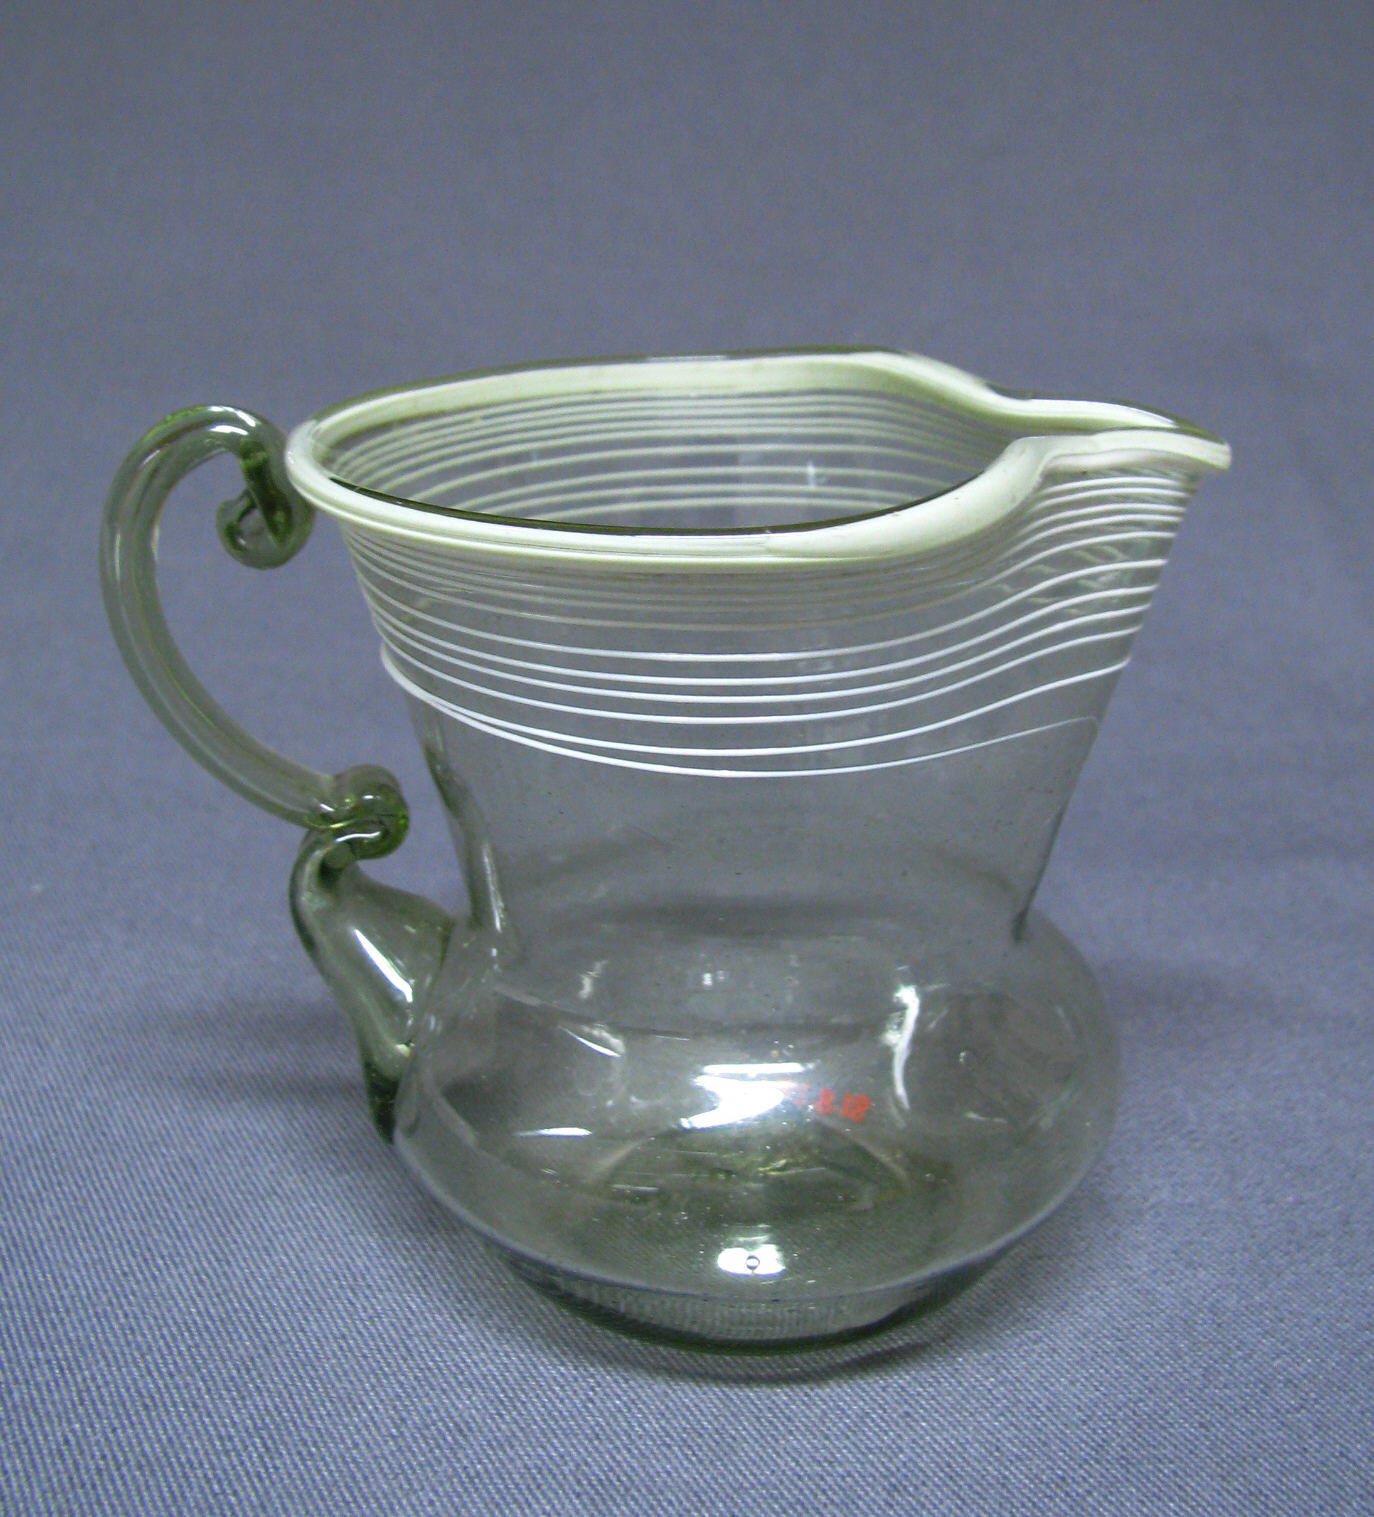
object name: jug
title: Jug (Pichet)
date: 1701-1800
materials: glass